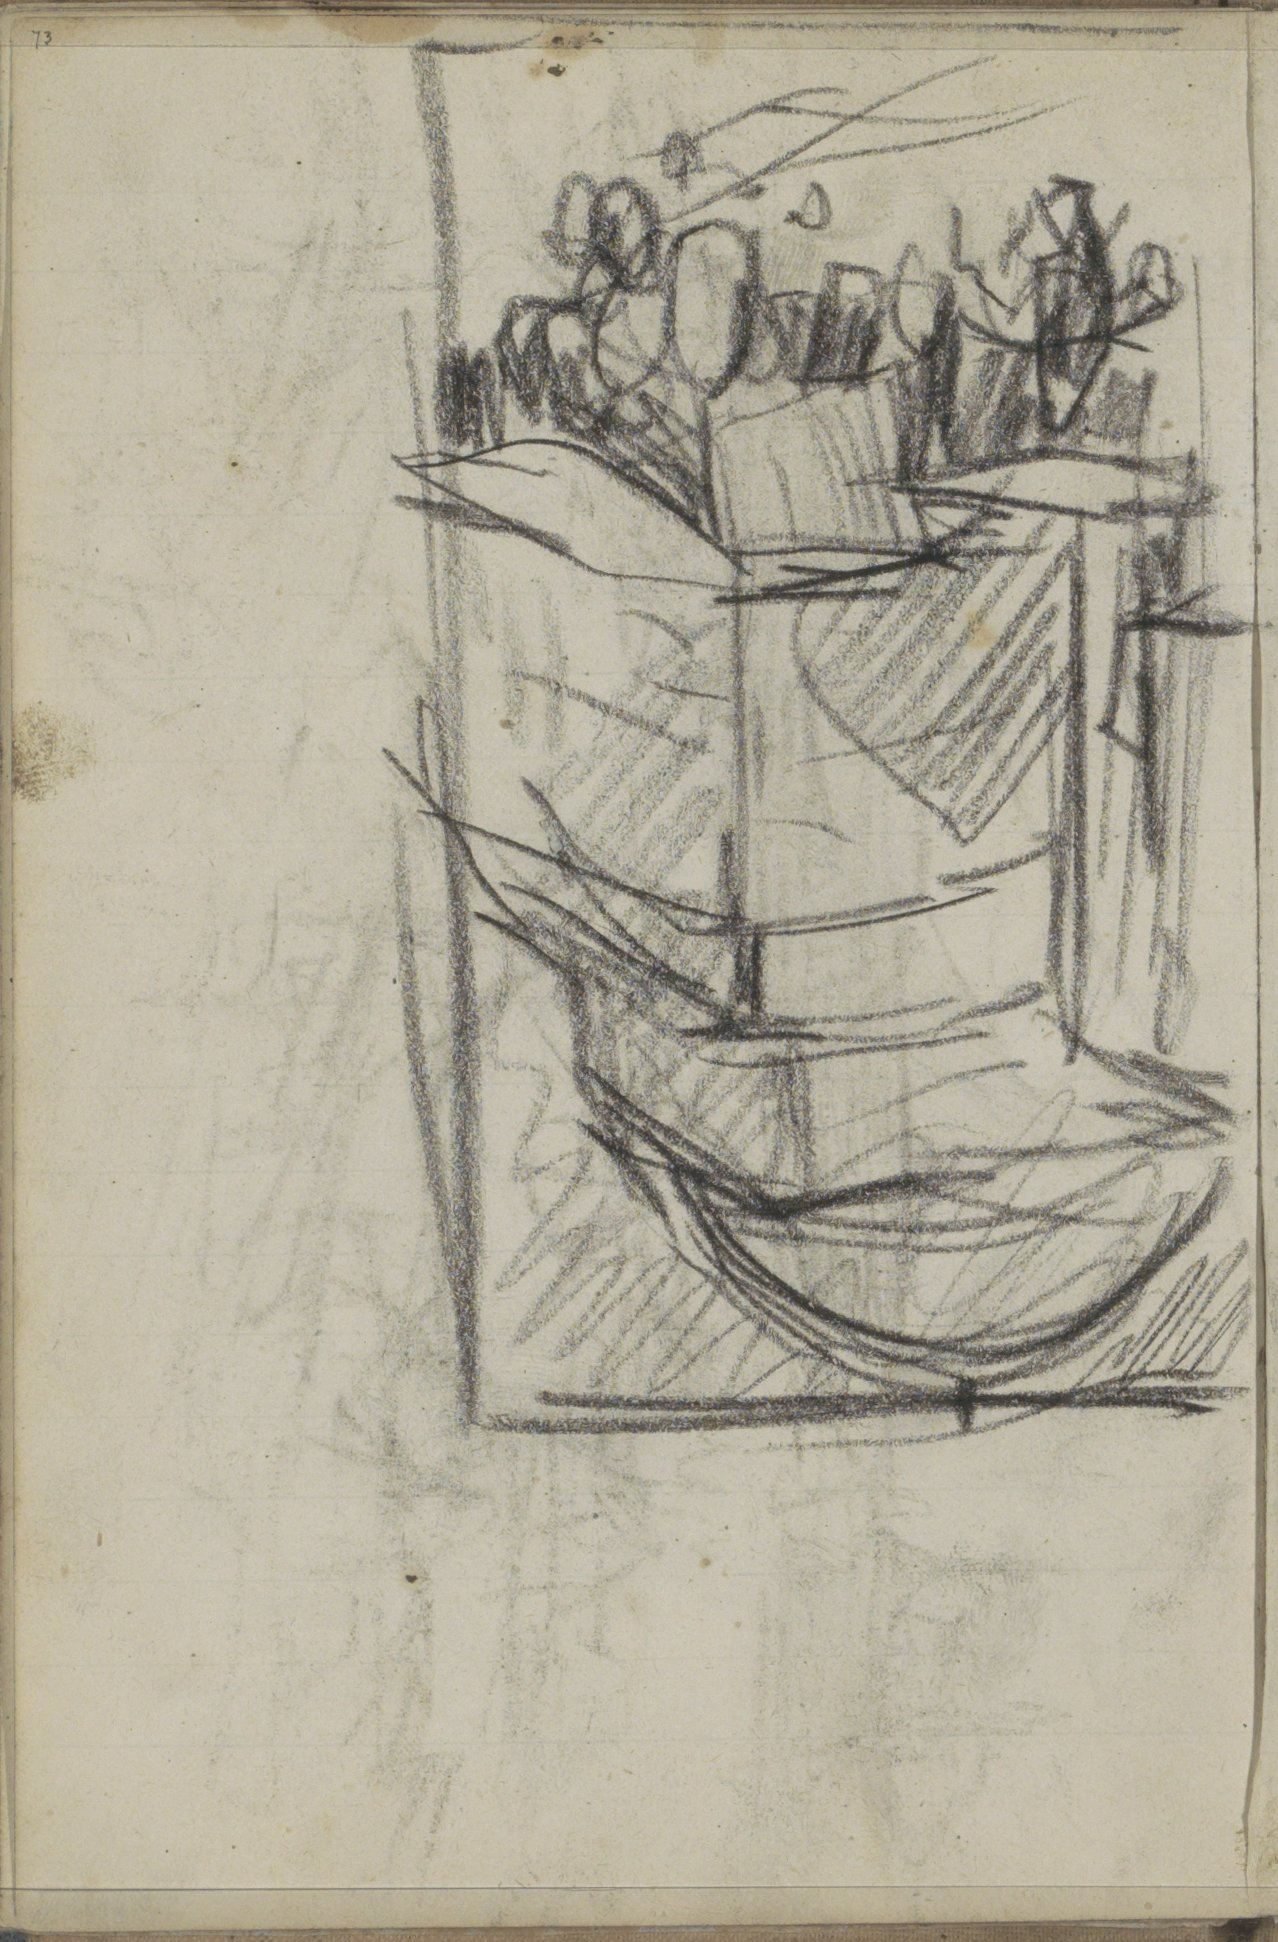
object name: sketchbook leaf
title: Straat met figuren en een gebouw met een koepeldak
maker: marius bauer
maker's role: draughtsman, print maker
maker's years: 1867-1932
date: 1888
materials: chalk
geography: istanbul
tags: dome ~ architecture, street (+ city(-scape) with figures, staffage)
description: Mogelijk de koepel van een moskee. Pagina 73 uit een schetsboek met 58 bladen.